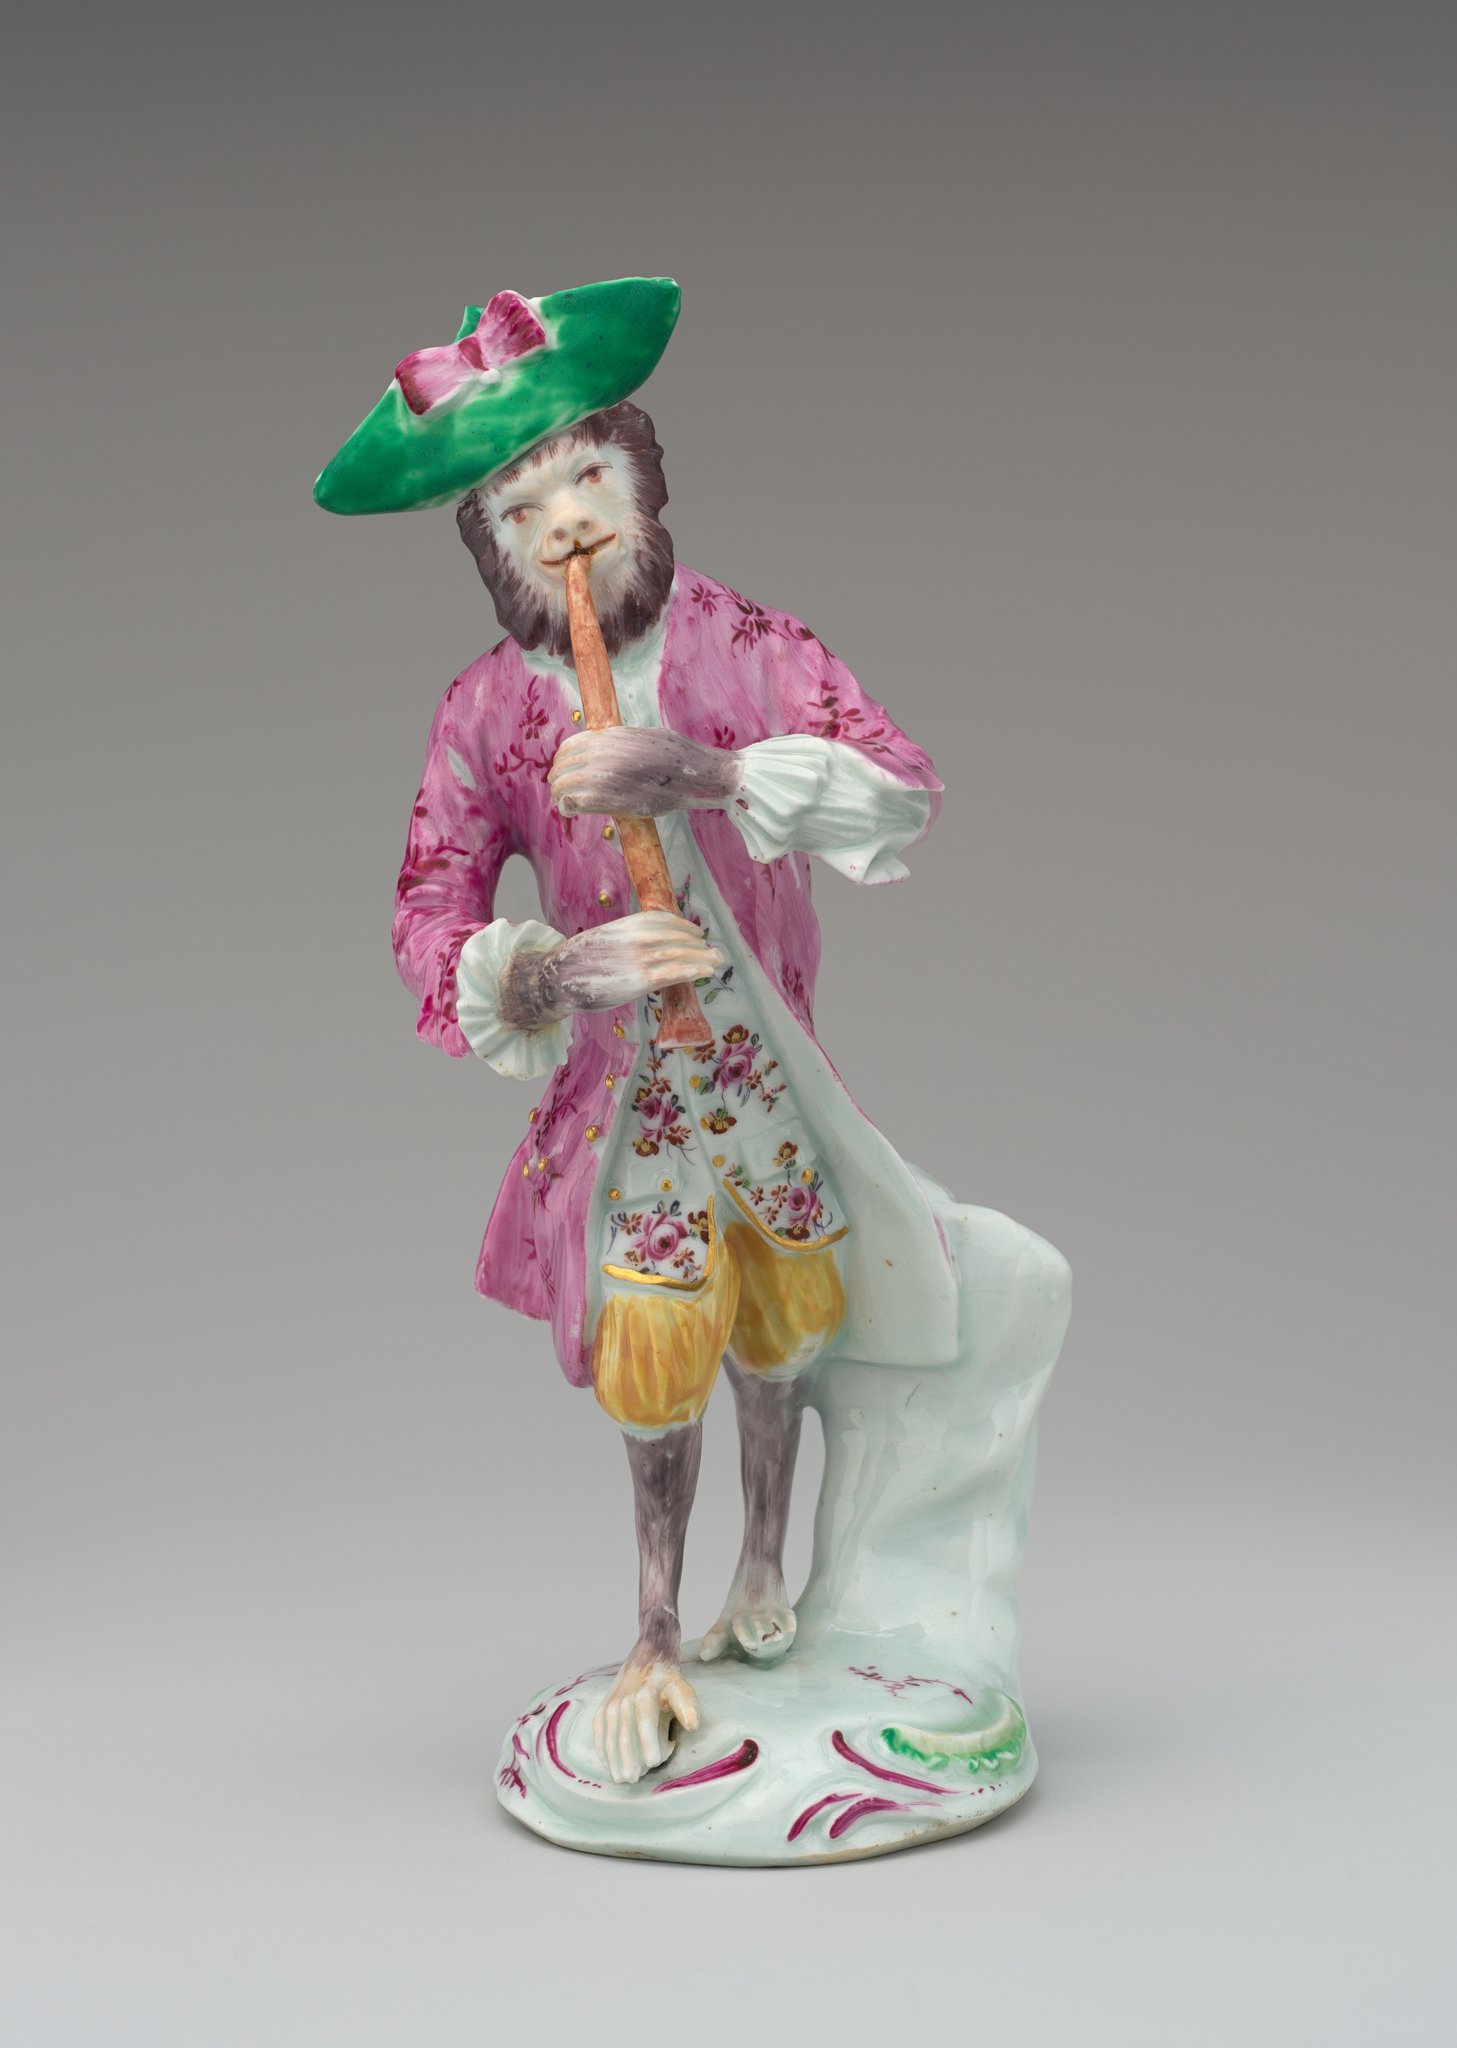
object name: figure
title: Monkey musician (part of a set)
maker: derby porcelain manufactory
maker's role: factory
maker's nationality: british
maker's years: 1751-1785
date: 1760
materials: soft paste porcelain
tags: horns,monkeys,musicians